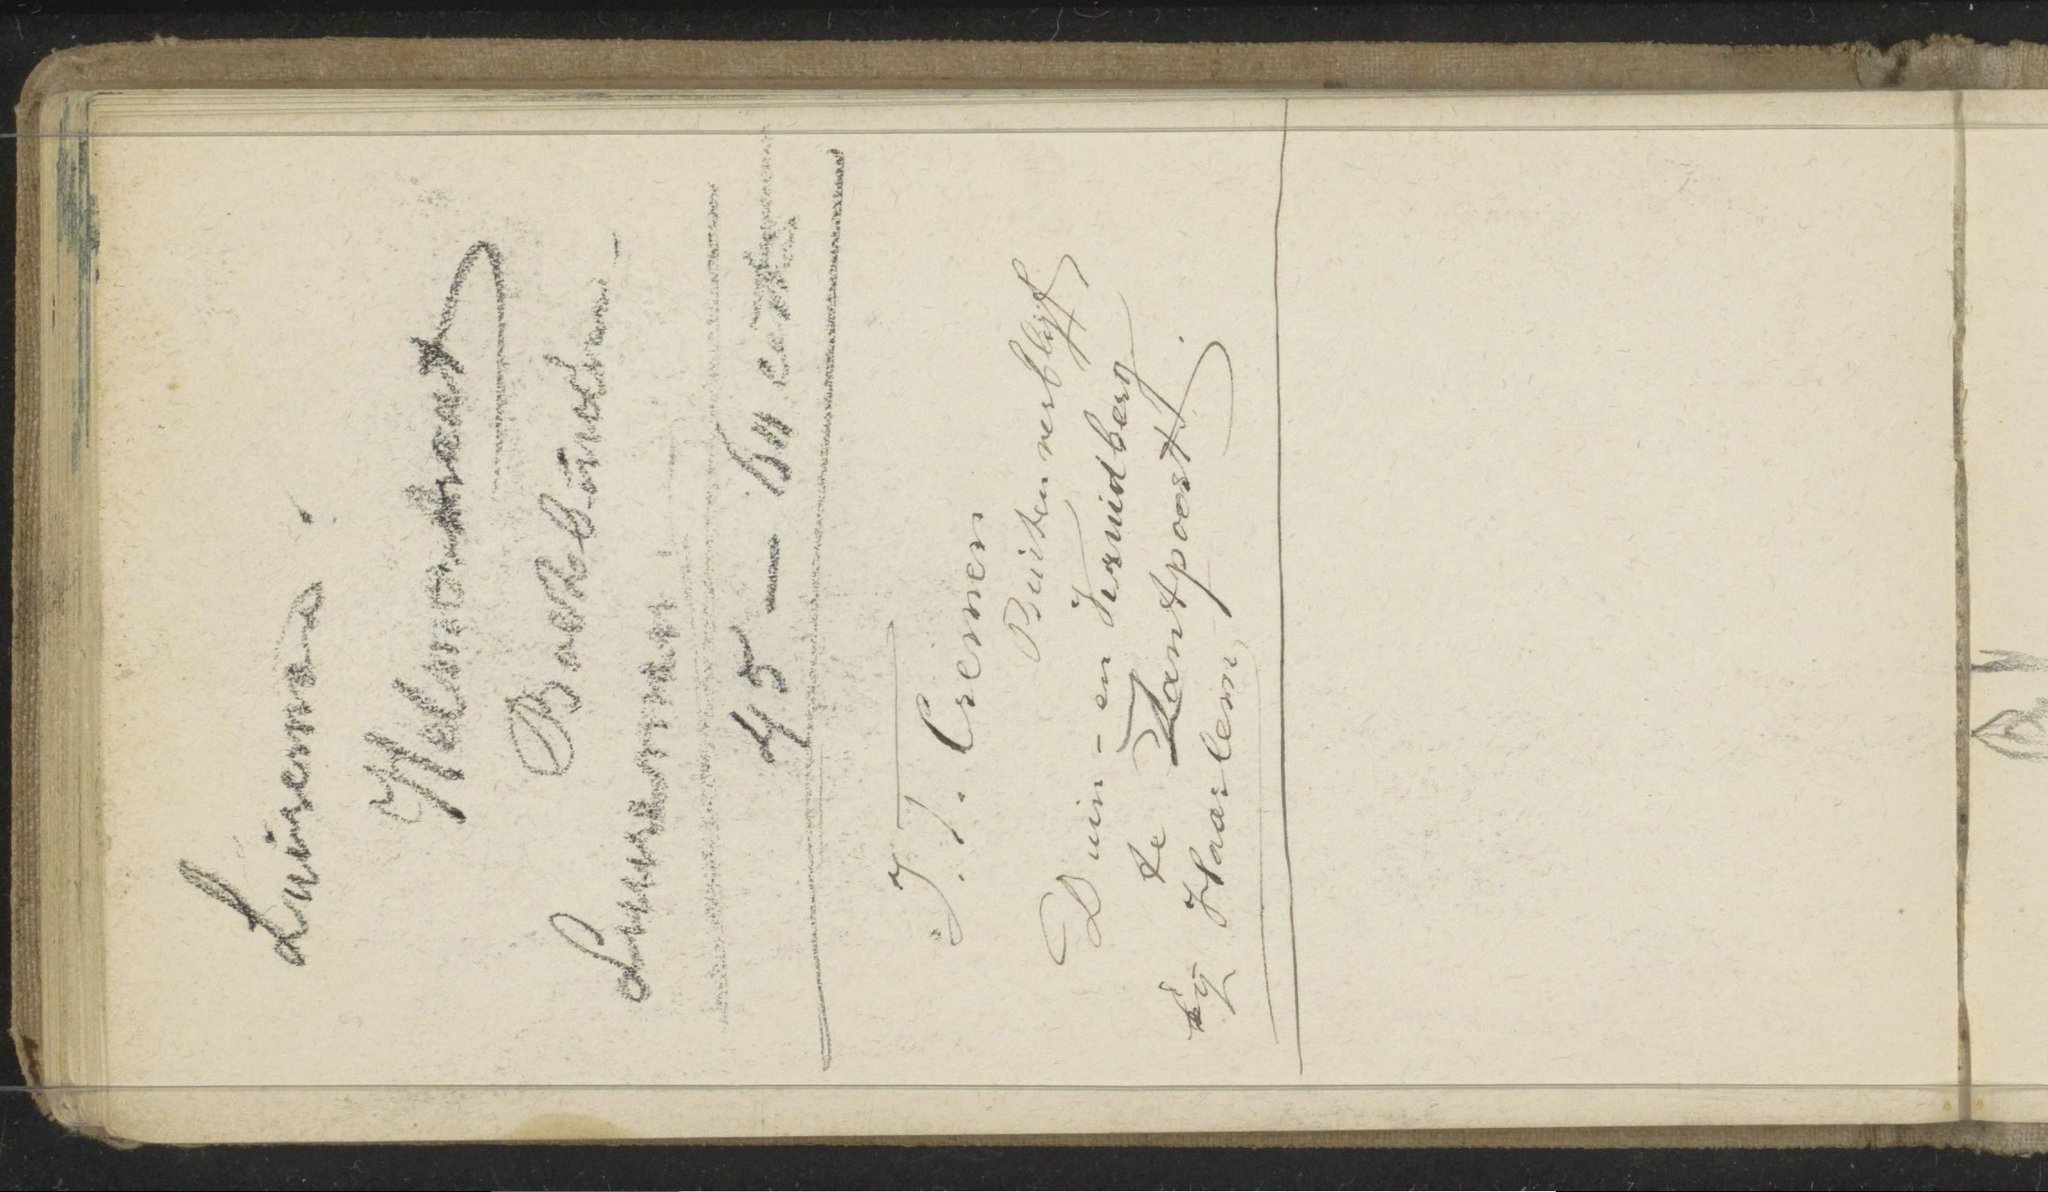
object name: sketchbook leaf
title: Adressen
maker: willem cornelis rip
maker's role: draughtsman, painter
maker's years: 1856-1922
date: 1895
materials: chalk, ink, paper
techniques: pen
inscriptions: address: ‘Luiseman/ Helmstraat/ Boekbinder/ [...]/ J.T. Cremer/ Buitenverblijf/ Duin- en Kruidberg/ te Zandpoort/ bij Haarlem’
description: Blad 38 verso uit een schetsboek met 39 bladen.